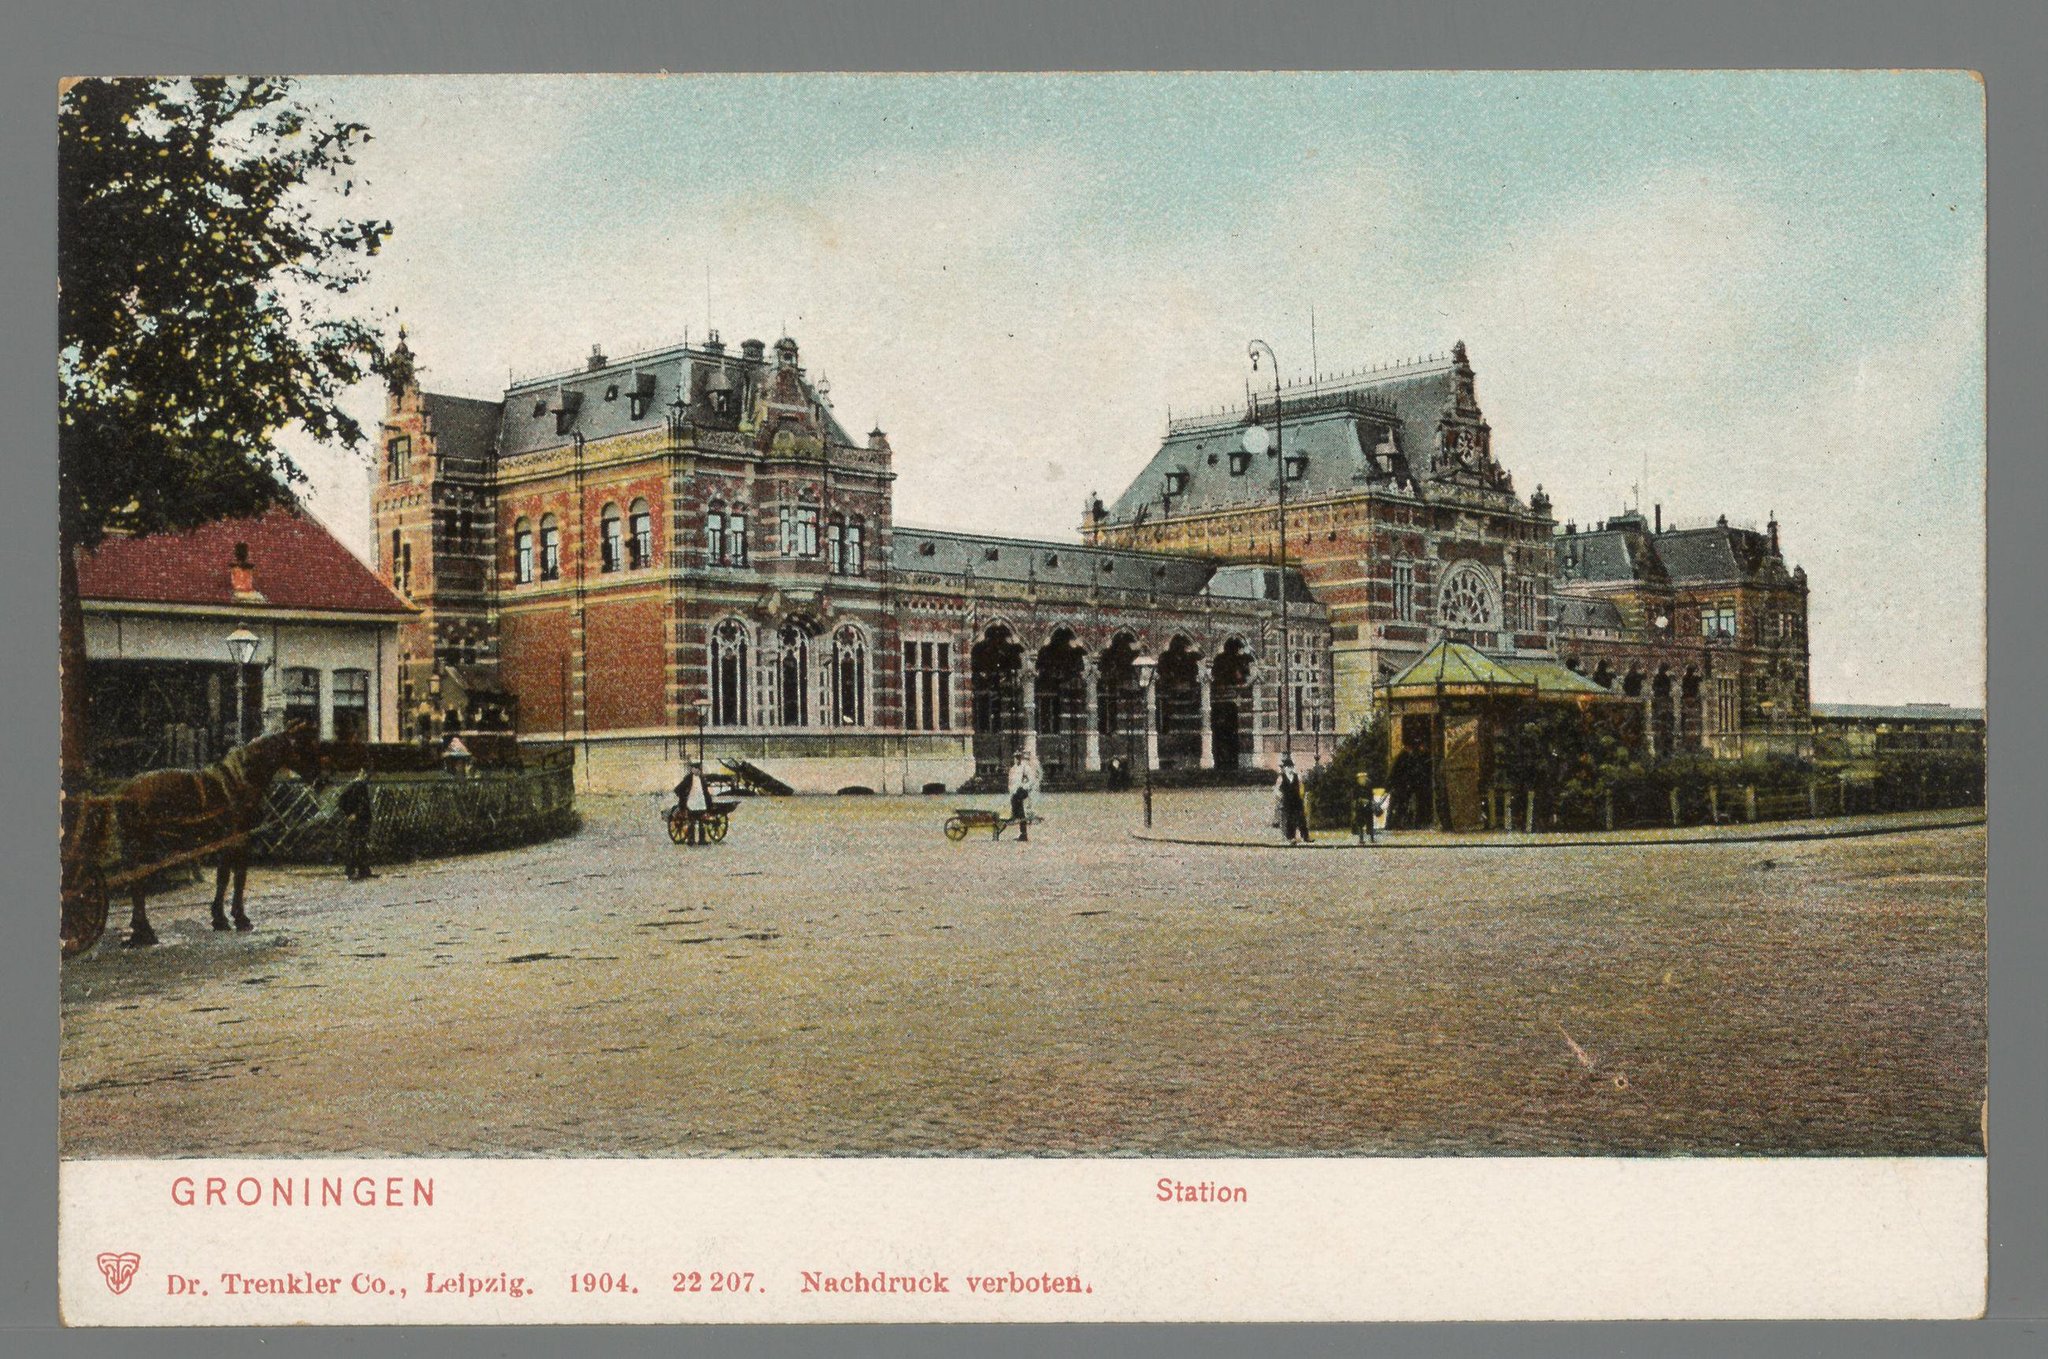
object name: ansichtkaart, prentbriefkaart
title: Groningen. Station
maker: Anonymous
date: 1904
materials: cardboard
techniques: lithograph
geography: leipzig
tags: station; shelter (railway, tramway)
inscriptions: date